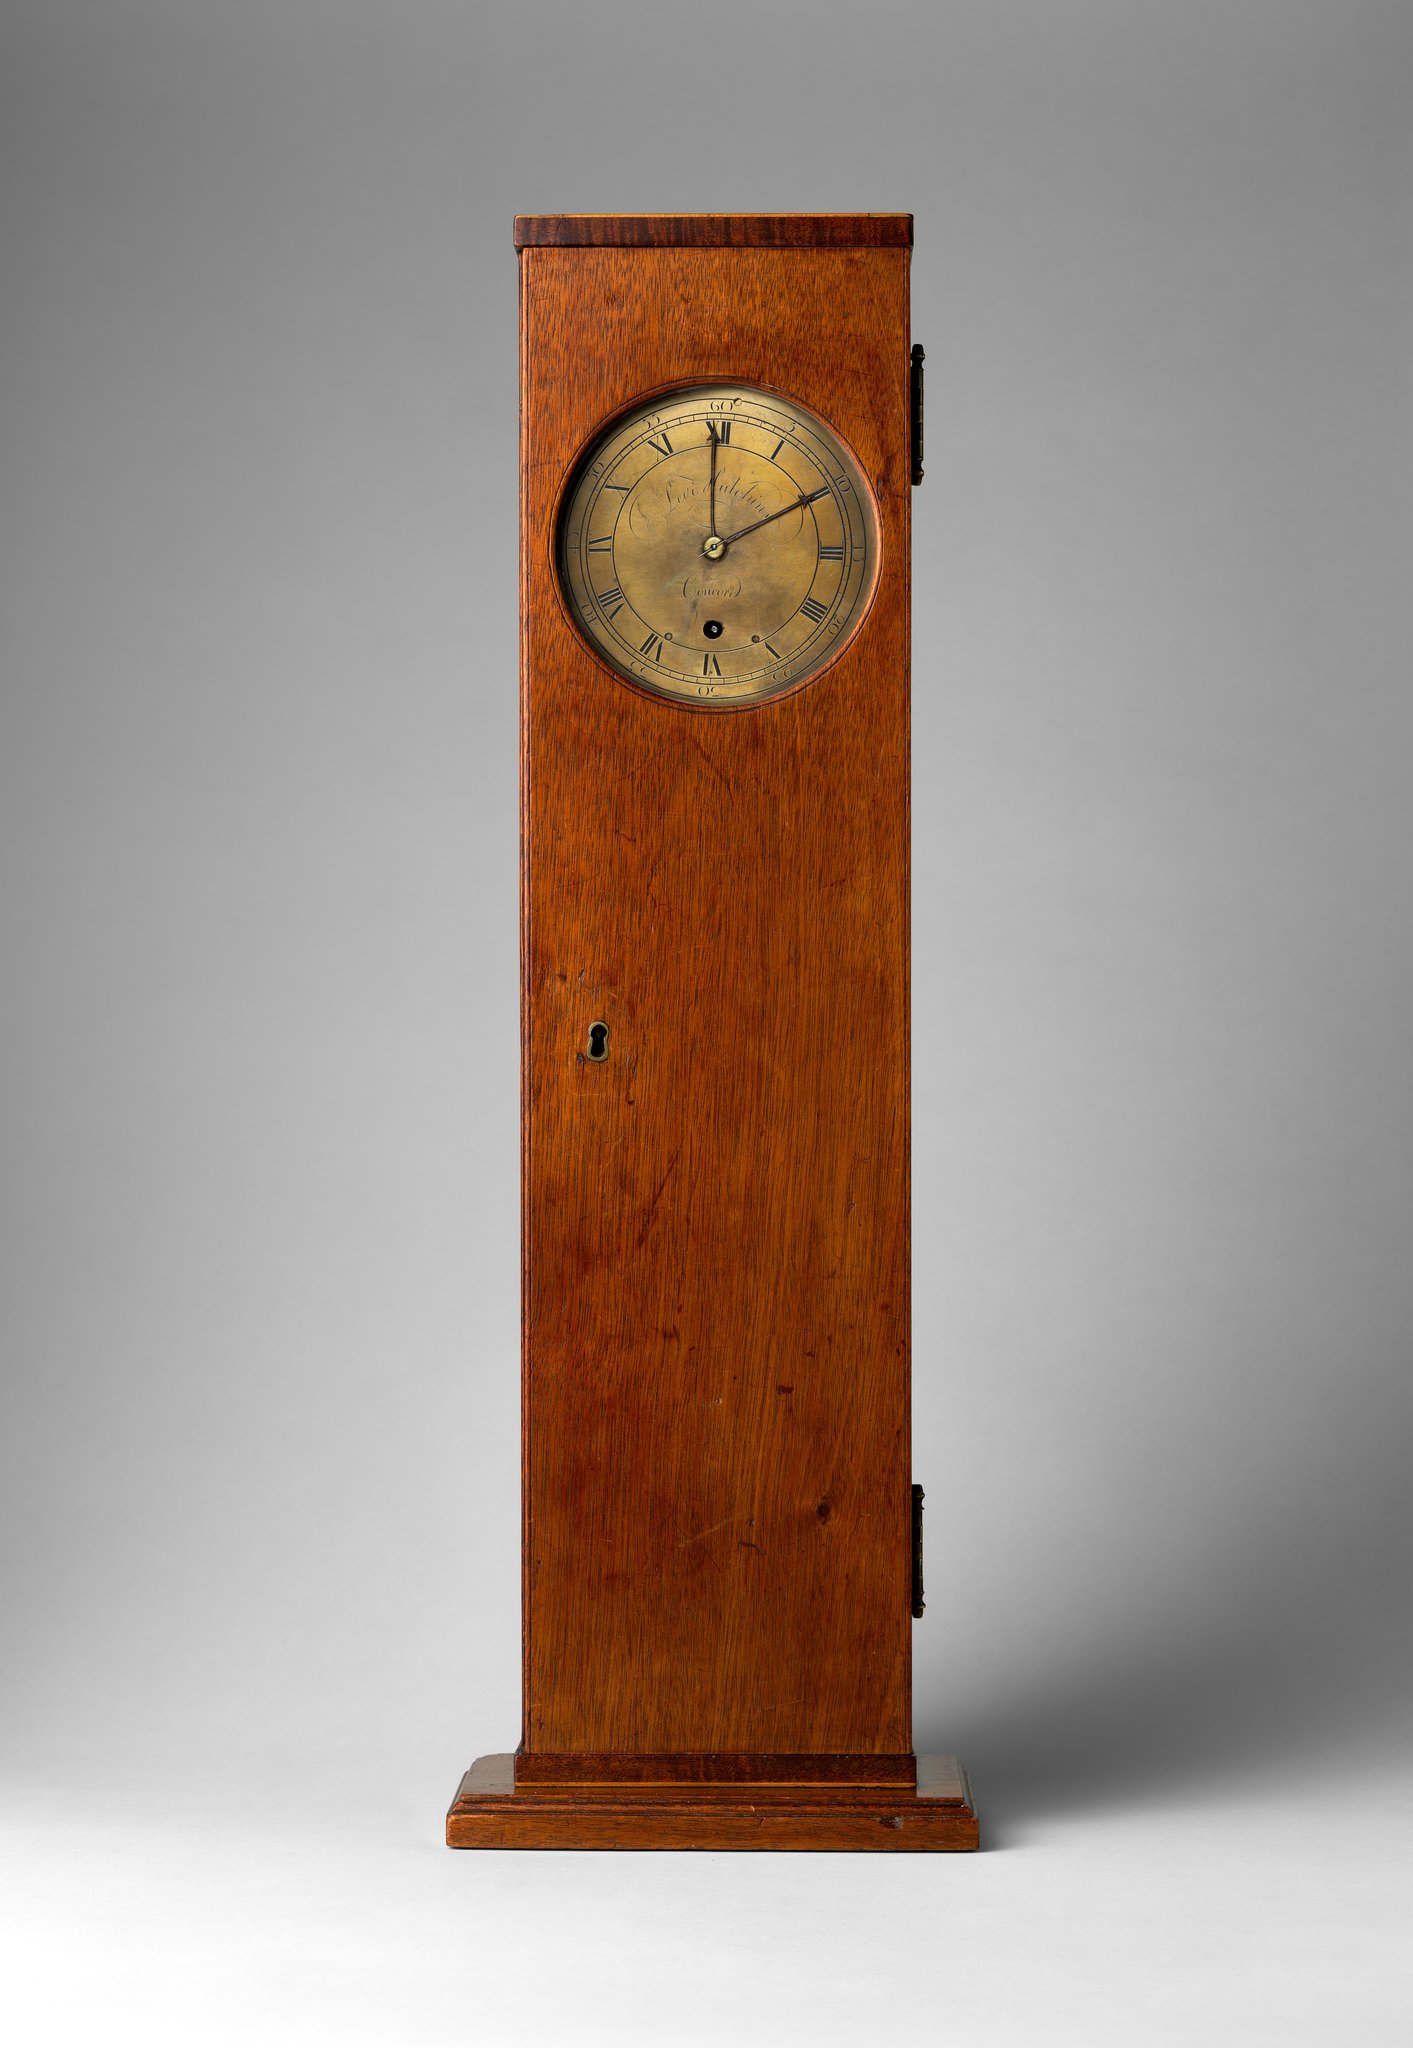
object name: shelf clock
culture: american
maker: levi hutchins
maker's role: maker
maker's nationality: american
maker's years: 1761-1855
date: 1786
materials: brass, iron, lead, wood, steel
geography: united states